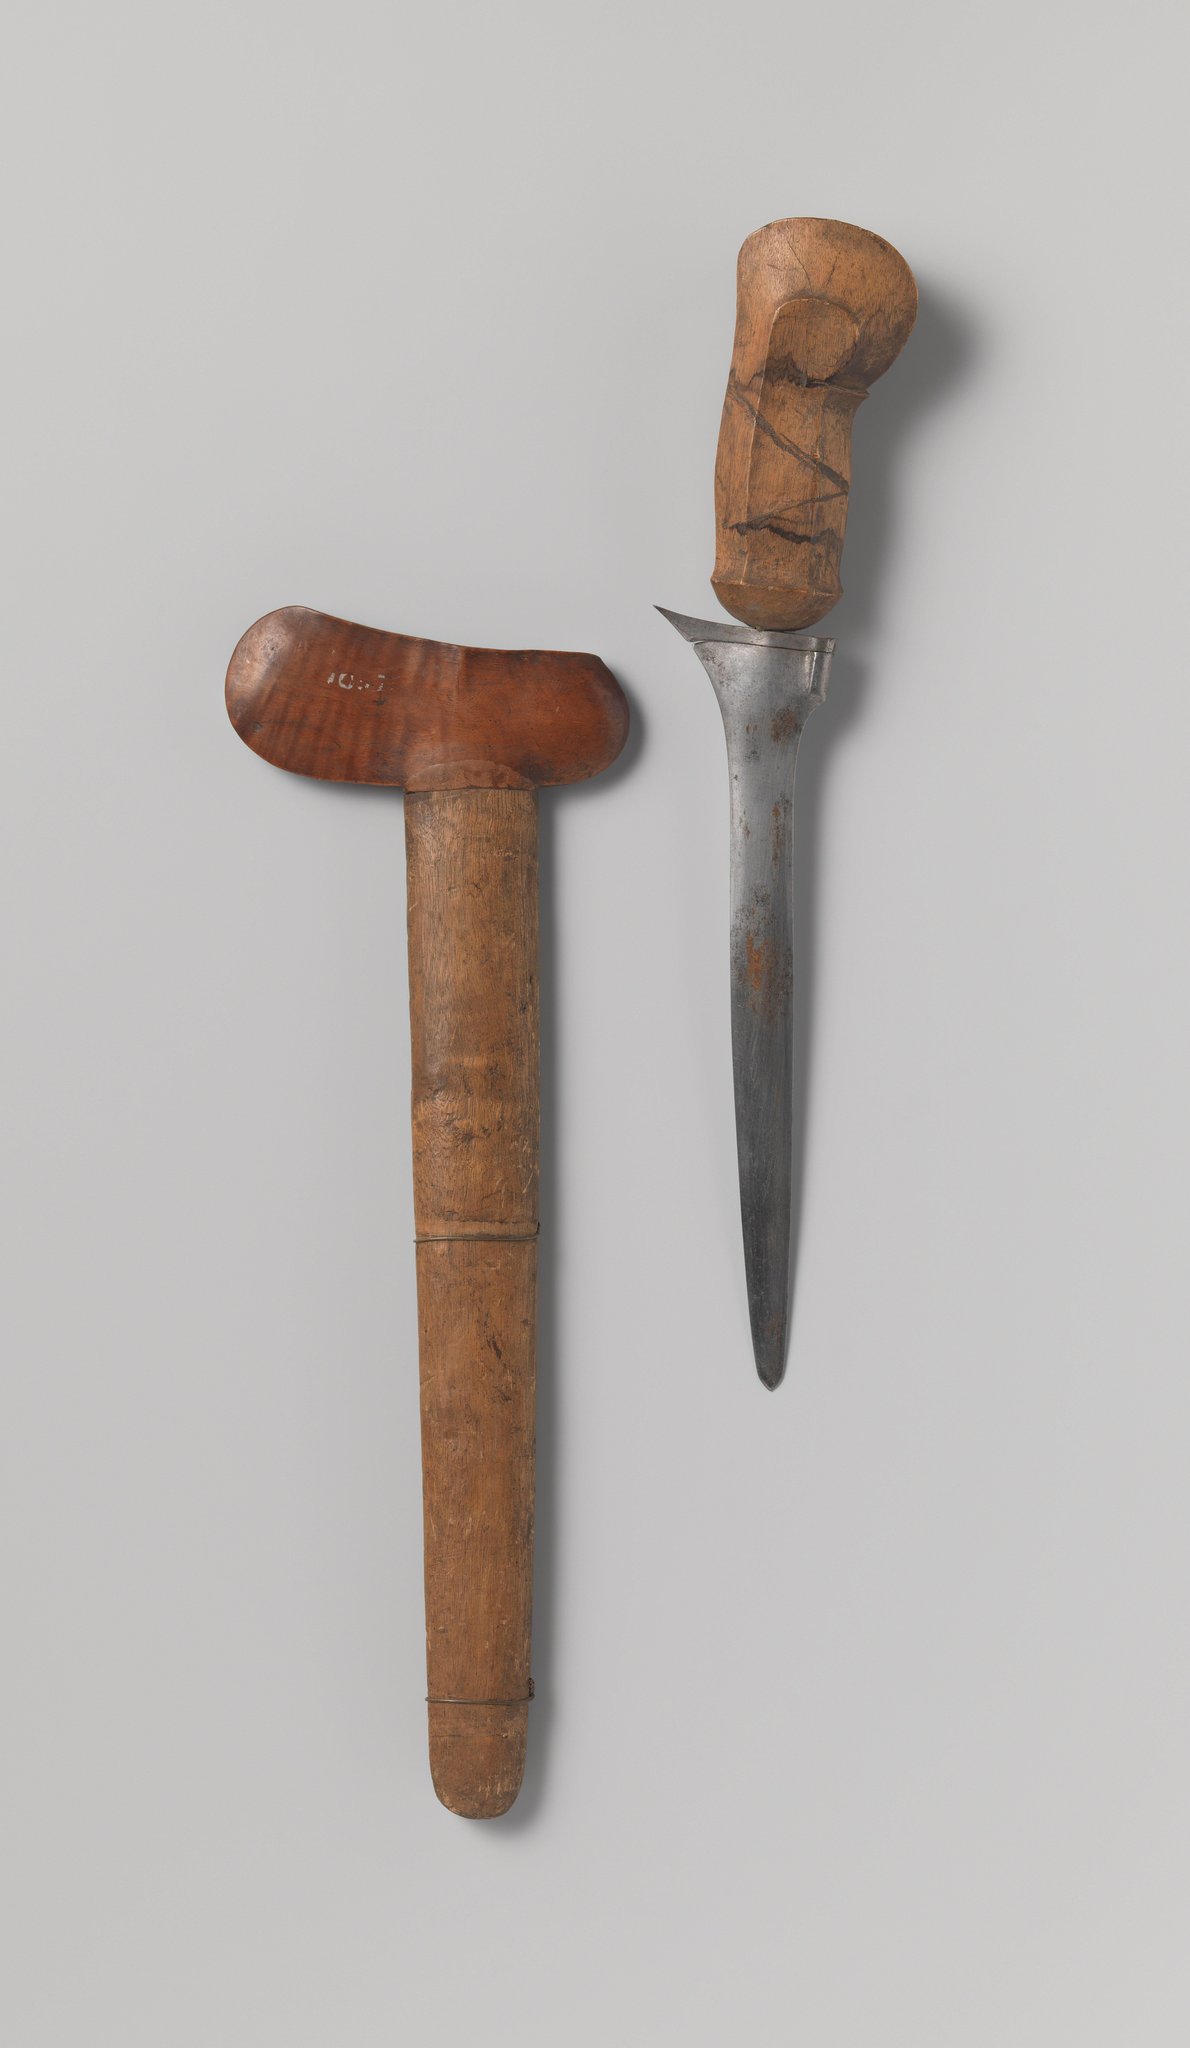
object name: kris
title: Kris van Bali met schede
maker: Anonymous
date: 1800-1899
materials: iron, wood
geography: bali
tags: lombok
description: Kris van Bali, eenvoudig model, in eenvoudige schede met een band er omheen. Het lemmet schijnt gebogen te zijn geweest. Buitgemaakt op de expeditie van Lombok in 1894.